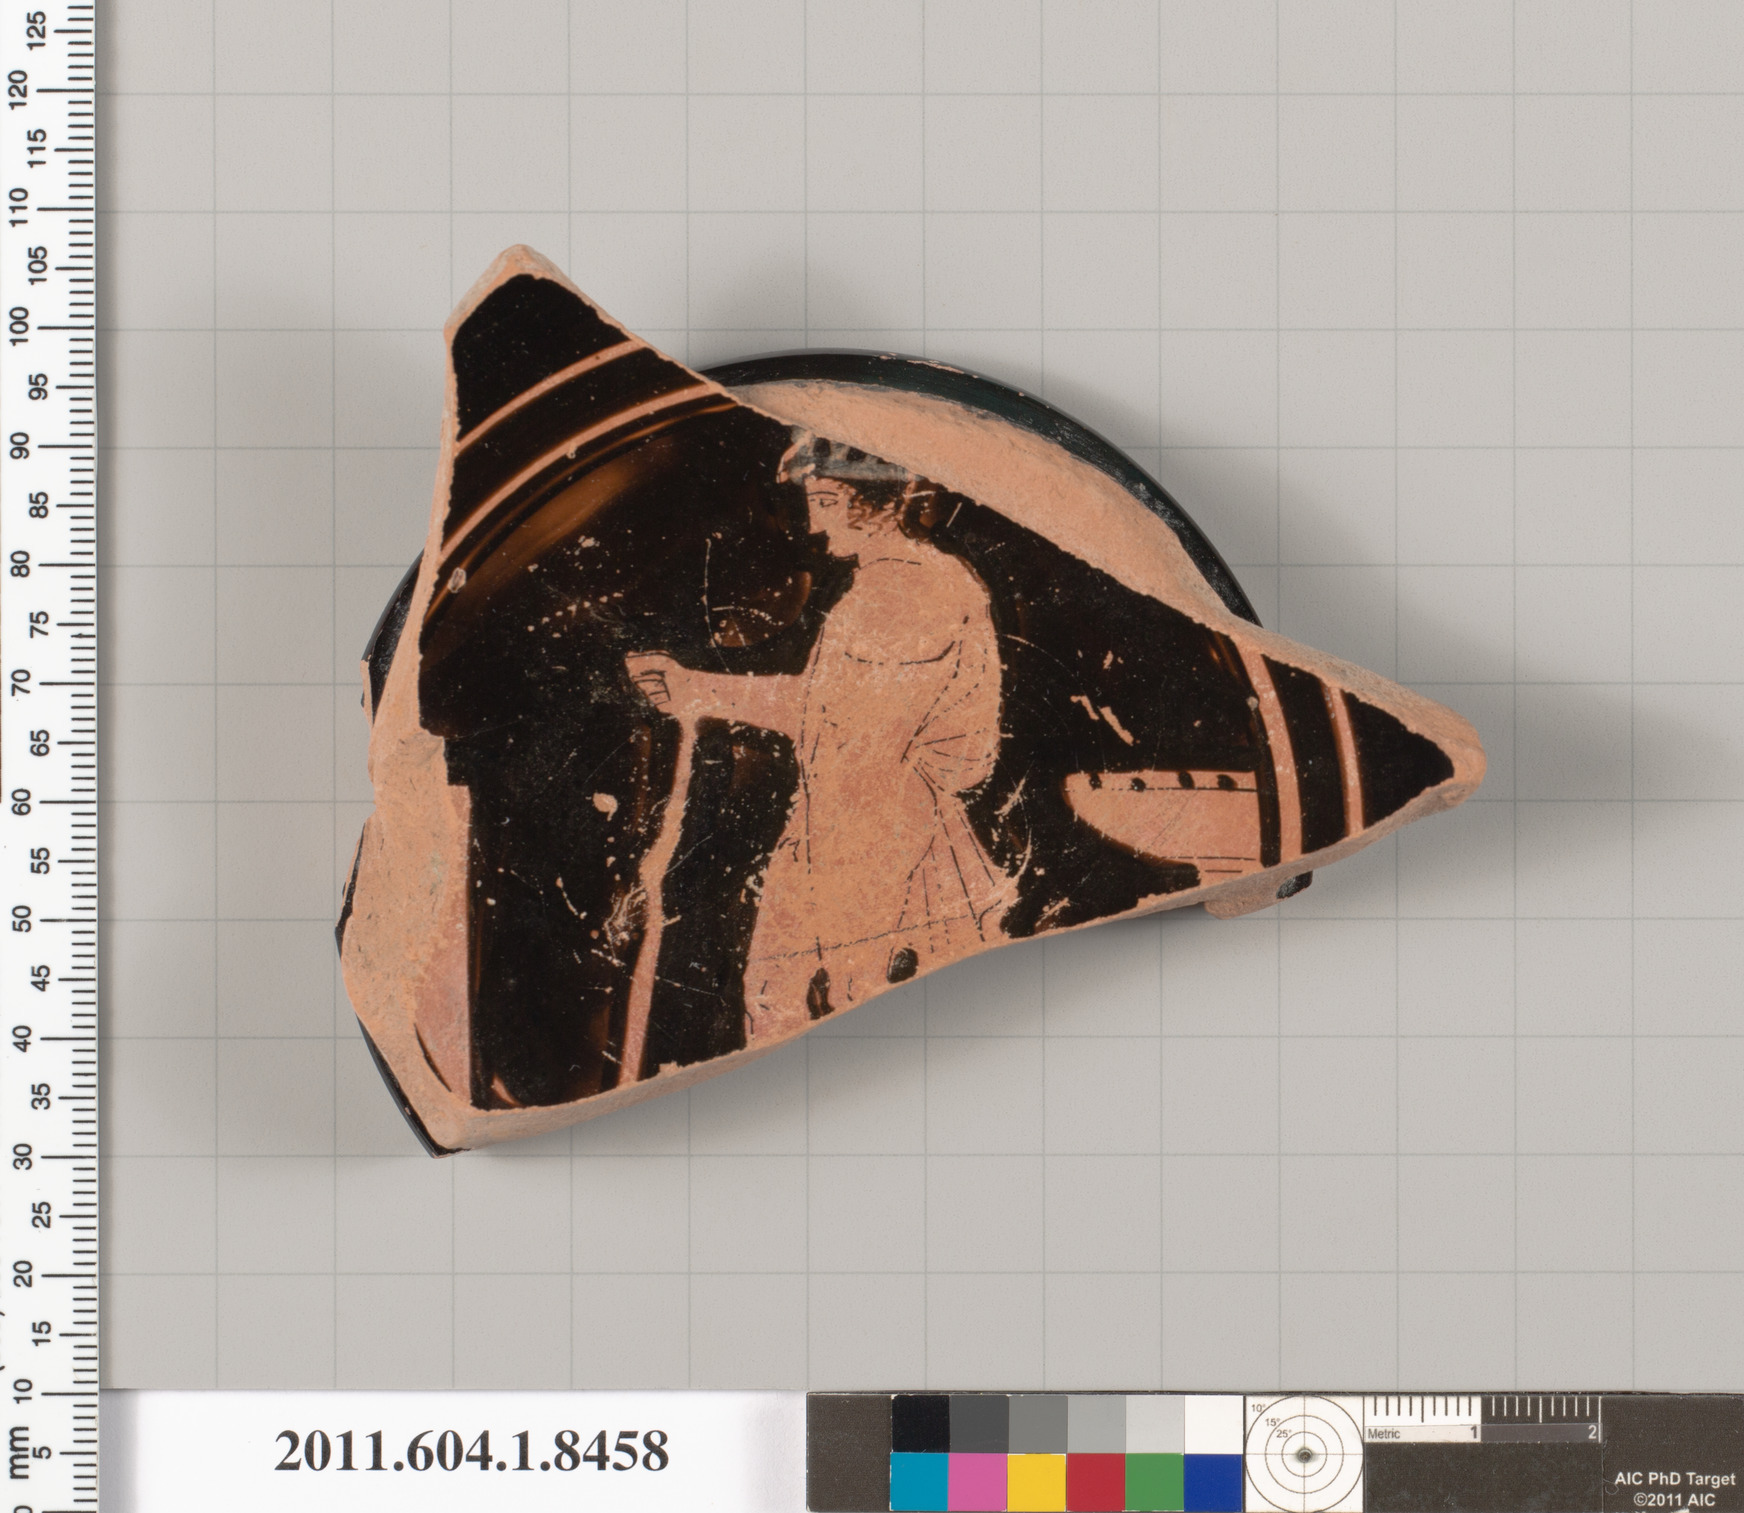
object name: kylix fragment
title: Terracotta fragment of a stemless kylix (drinking cup)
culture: greek, attic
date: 460-450 BCE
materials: terracotta